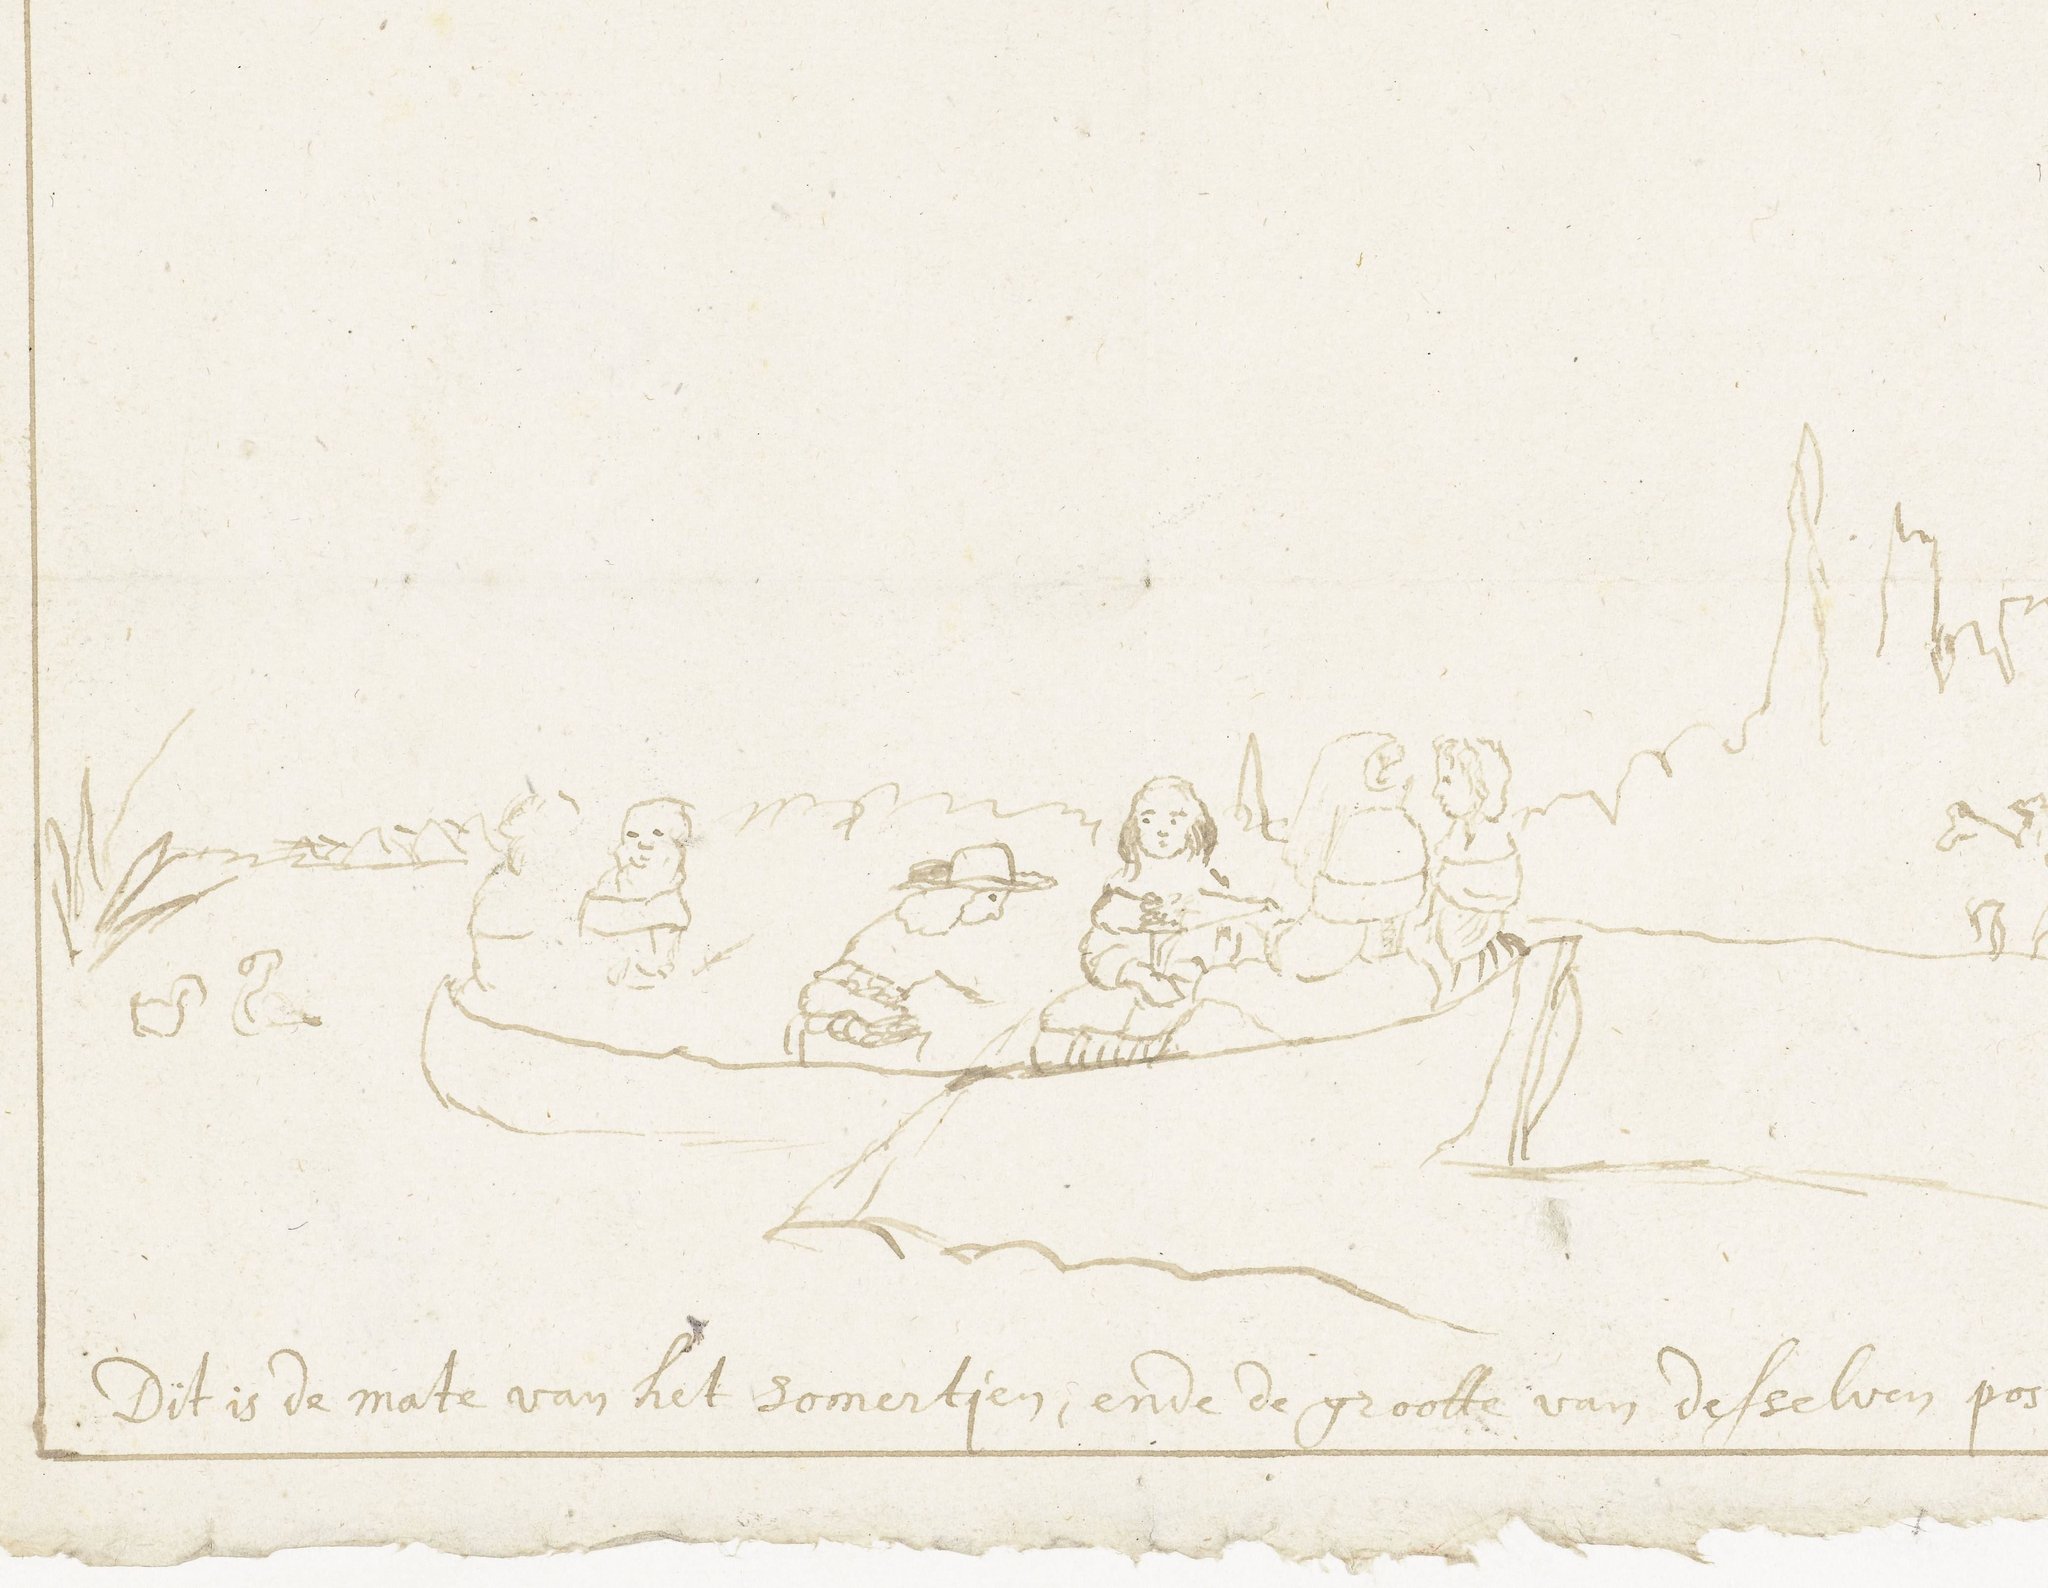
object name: drawing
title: Zomer: een gezelschap op een boot in de singel van Zwolle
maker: gesina ter borch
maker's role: draughtsman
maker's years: 1633-1690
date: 1655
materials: ink, paper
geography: zwolle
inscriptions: inscription: ‘Dit is de maet van het somertjen, ende de grootte van desselven postuertjens’, inscription: ‘Een grijse winter komt na groene somer-dagen,/ soo 't oock alhier soo deed', dat souw mij veel behagen:’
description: De tekening is mogelijk een kopie naar Harmen, maar waarschijnlijker is dat het een kopie is naar een verloren origineel van Gesina zelf. Pendant van RP-T-00-60.